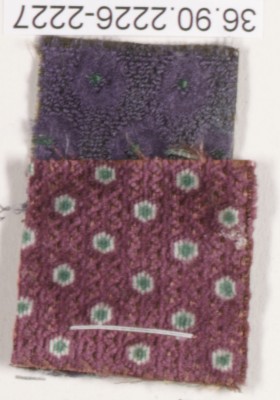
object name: piece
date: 1801-1900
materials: silk